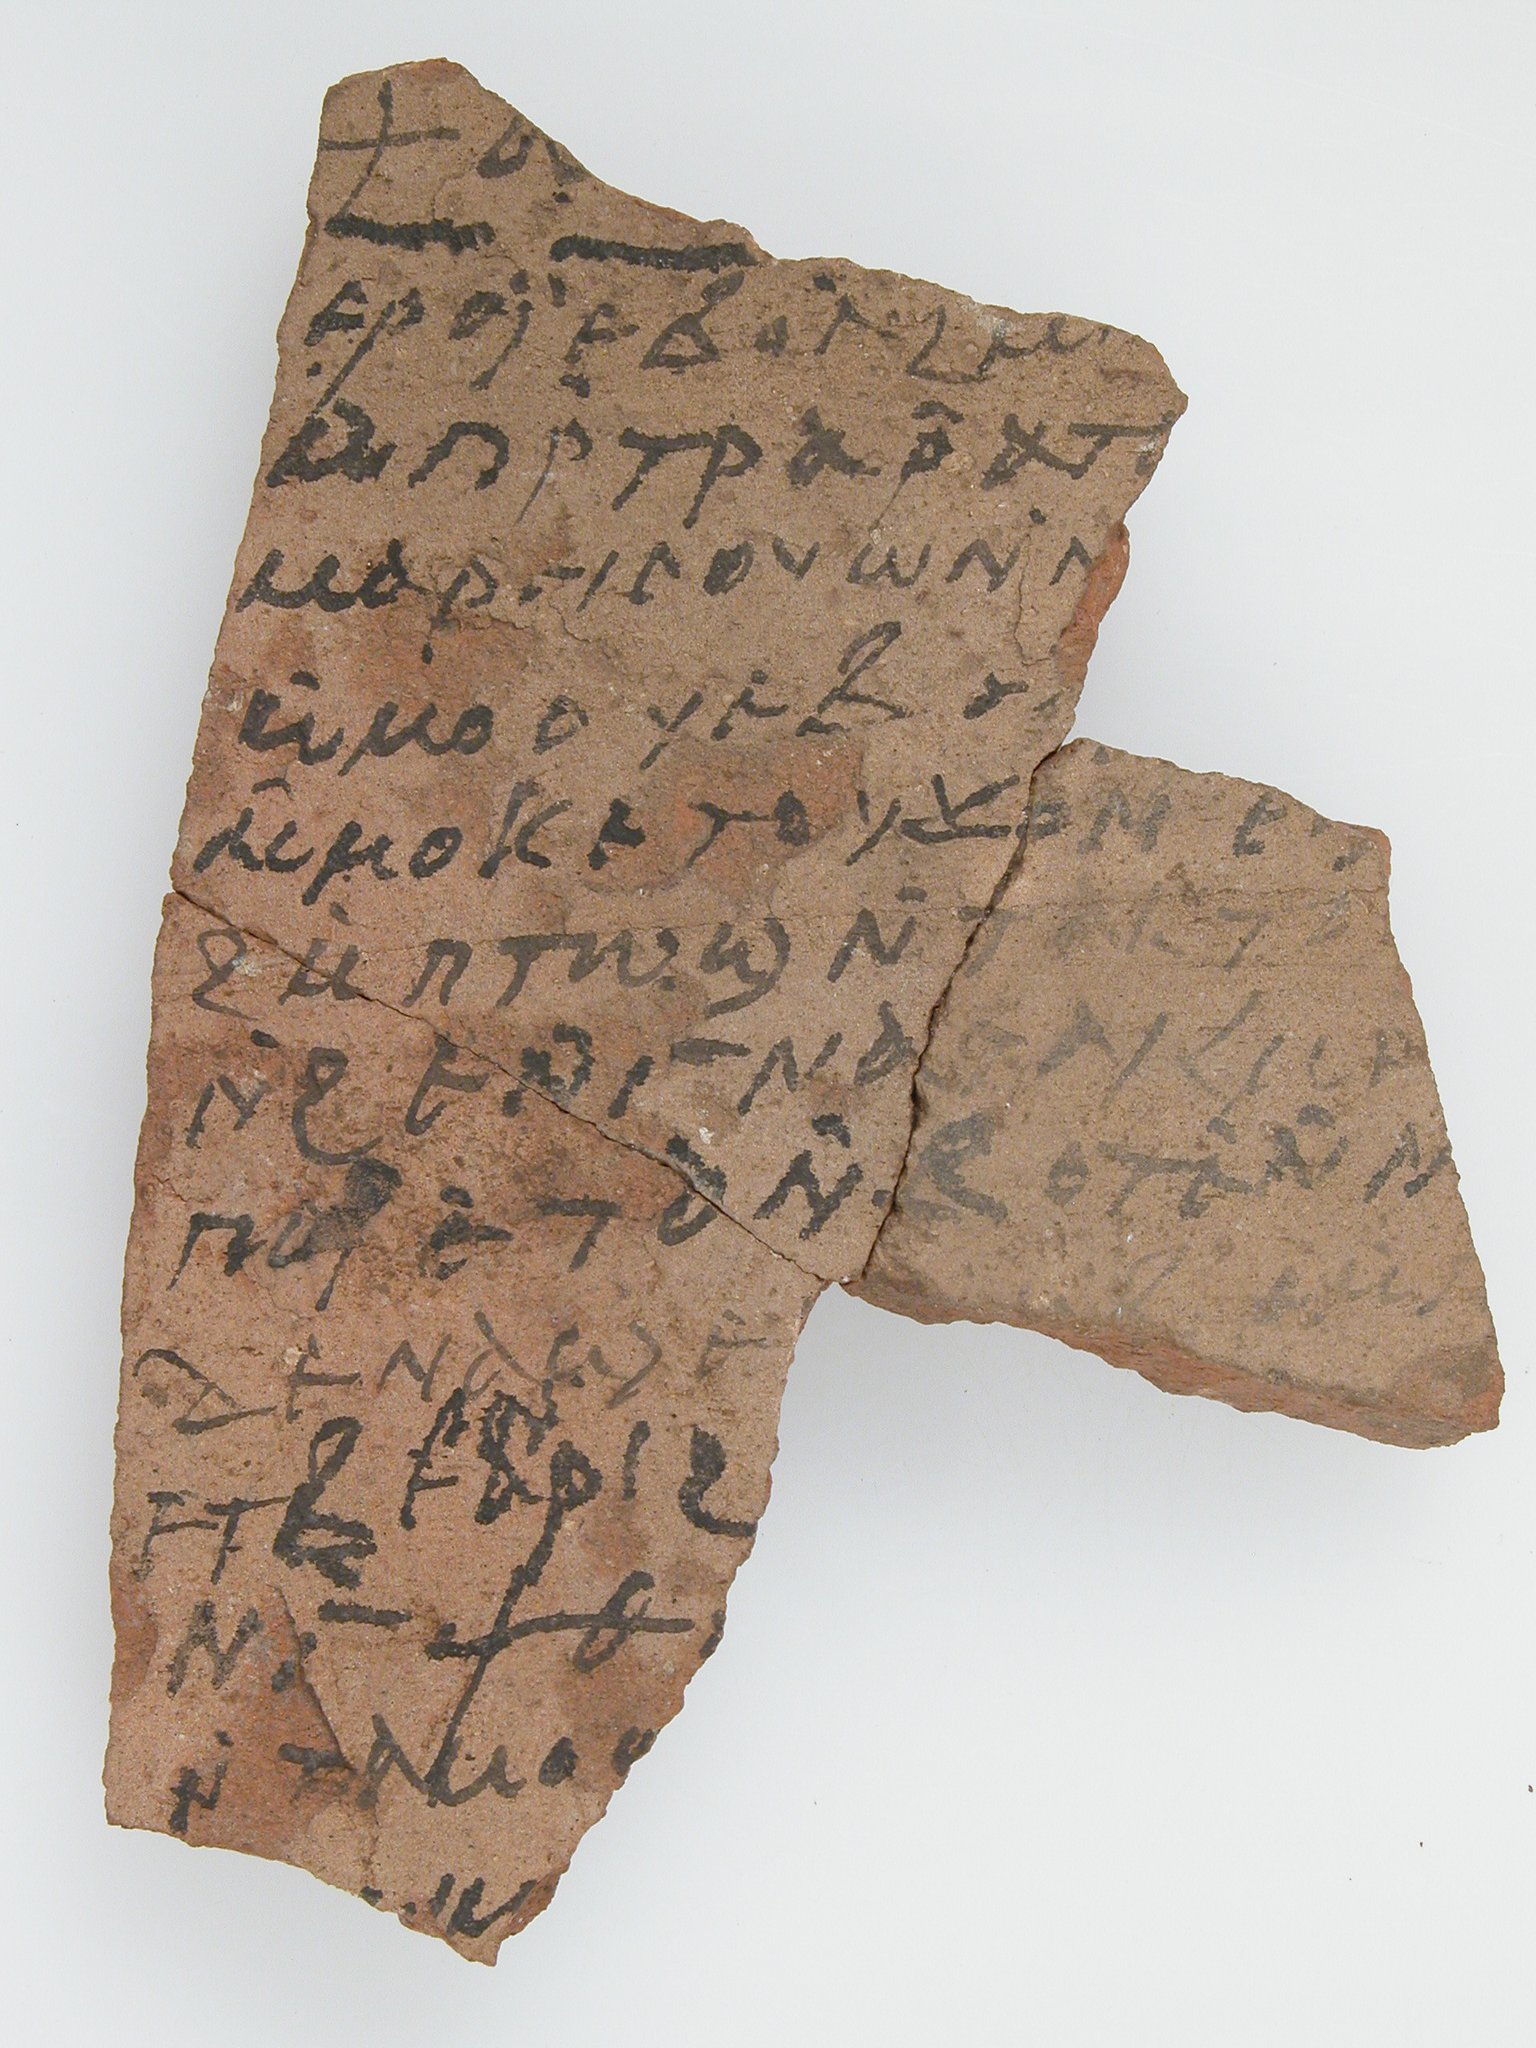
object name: ostrakon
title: Ostrakon with Liturgical Text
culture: coptic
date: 600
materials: ink, pottery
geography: egypt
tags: coptic